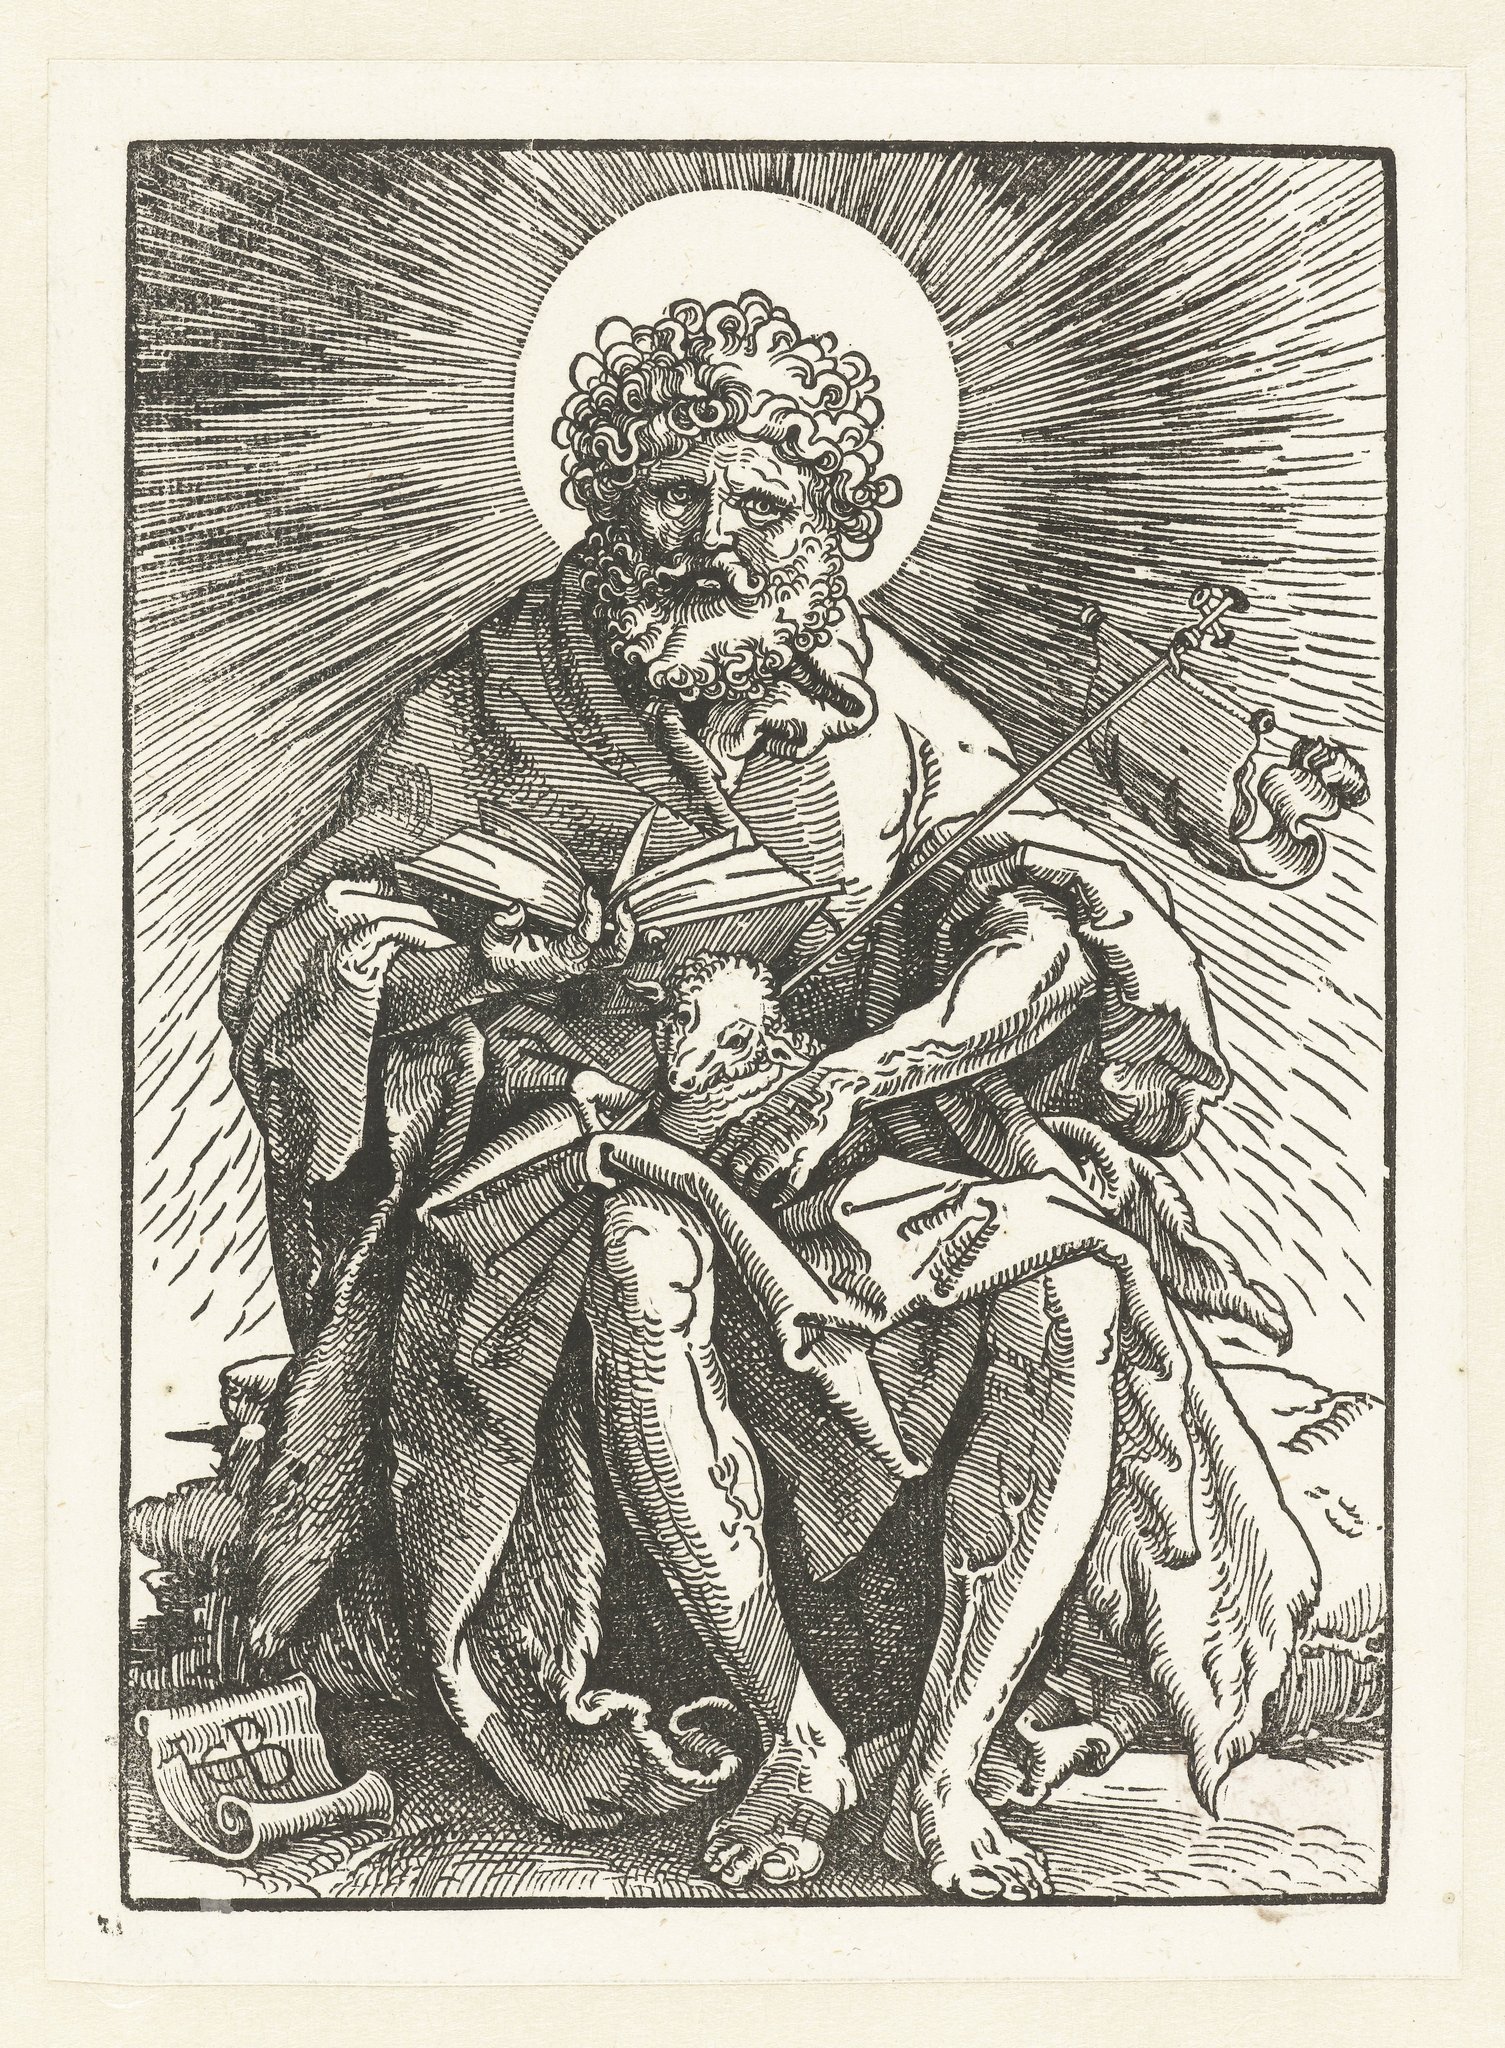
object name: print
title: Johannes de Doper met het Lam Gods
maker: hans baldung grien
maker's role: draughtsman, print maker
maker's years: 1484-1545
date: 1517-1521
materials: paper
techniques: woodcut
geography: straatsburg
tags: john the baptist; possible attributes: book, reed cross, baptismal cup, honeycomb, lamb, staff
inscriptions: collector's mark: Lugt 240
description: Johannes de Doper zittend met het Lam Gods op zijn schoot. Het Lam draagt met een voorpoot het kruisvaandel.